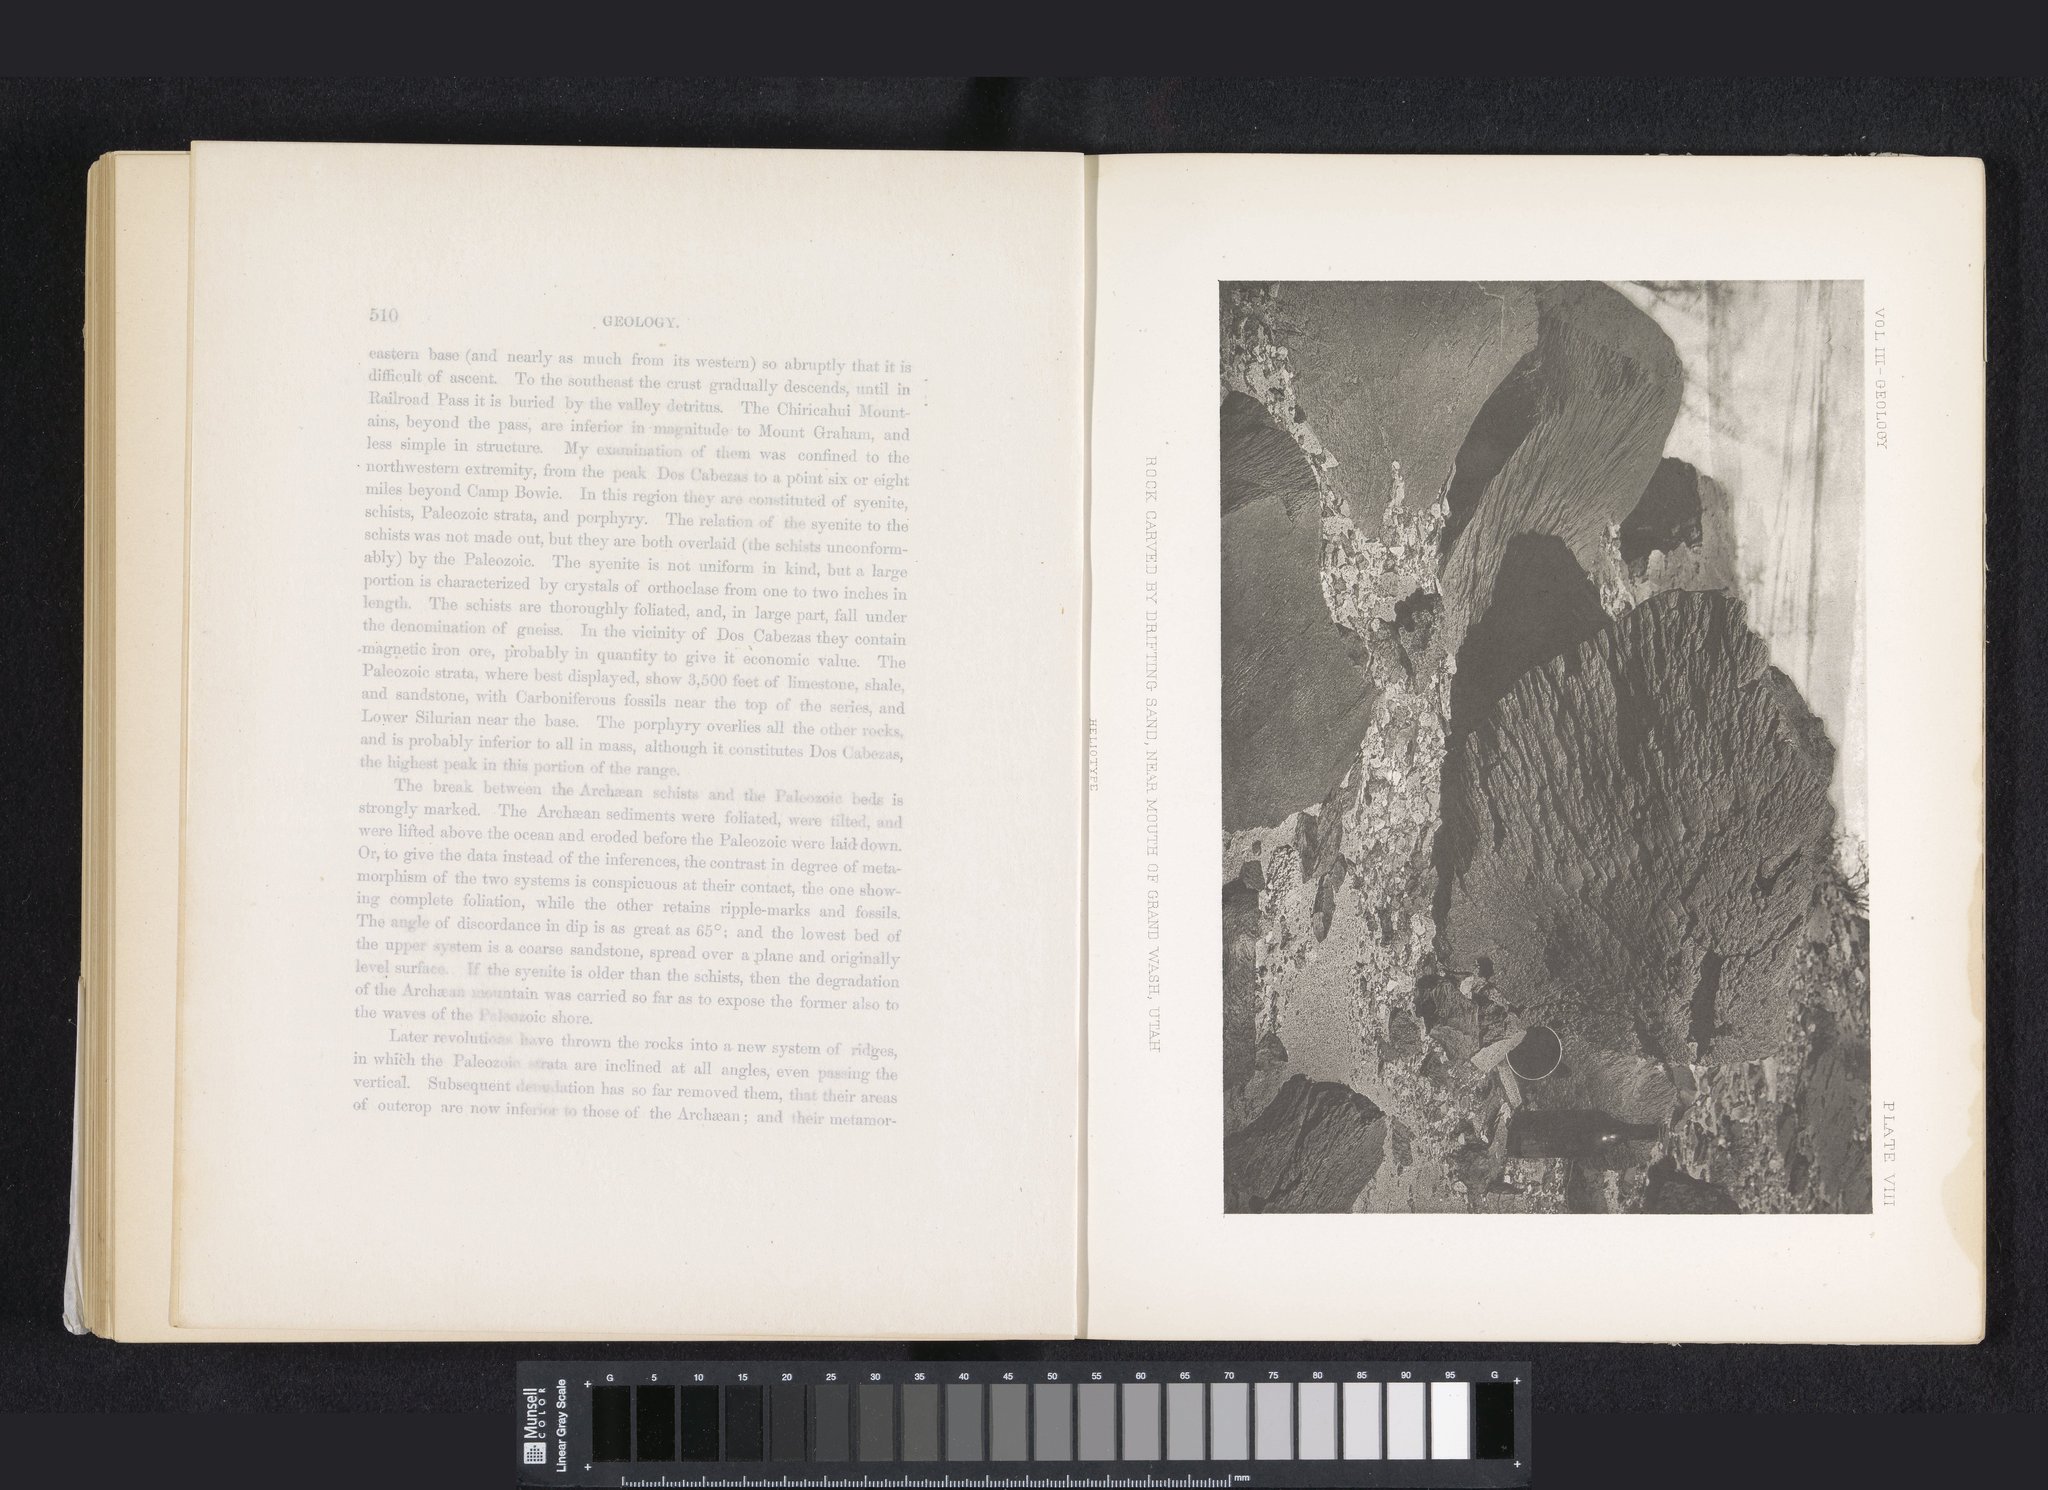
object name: page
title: Rock carved by drifting sand, near mouth of Grand Wash, Utah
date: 1871-1875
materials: paper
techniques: photograph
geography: utah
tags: ravine, chasm, abyss, canyon, rock-formations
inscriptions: number: ‘Plate VIII’